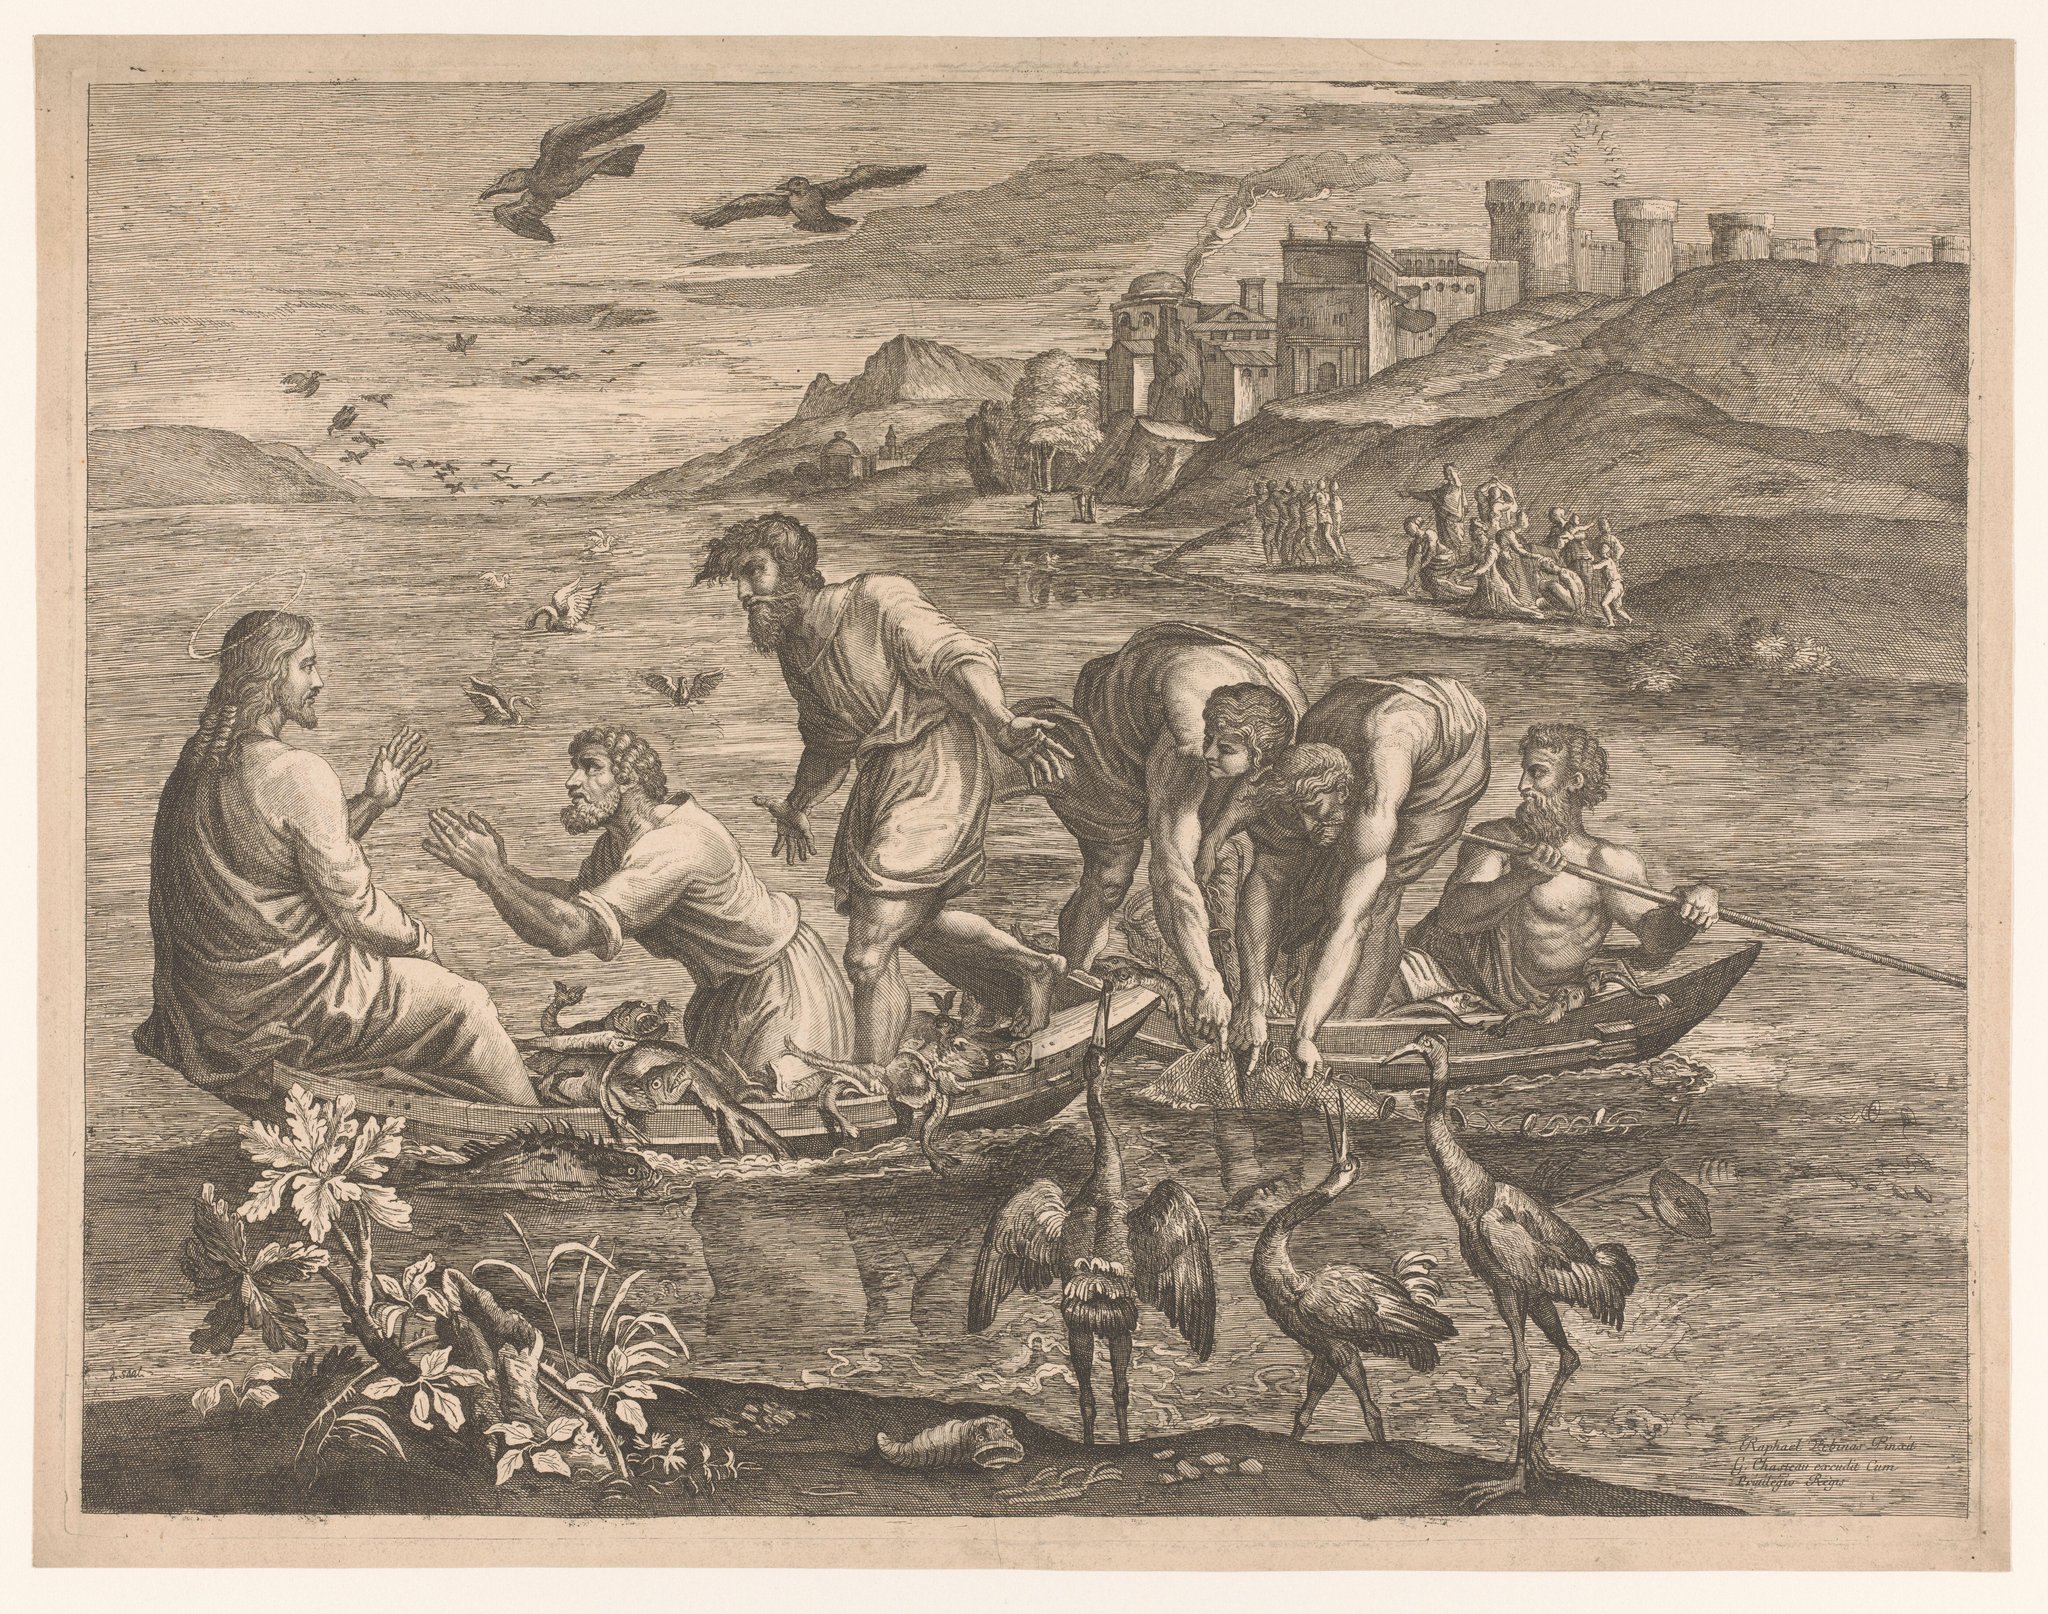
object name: print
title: Wonderbare visvangst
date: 1673-1678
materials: paper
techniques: etching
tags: the miraculous draught of fishes (before the resurrection) on the lake of gennesaret (sea of galilee); james and john helping to bring in the nets (luke 5:1-11)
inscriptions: collector's mark: Lugt 2228